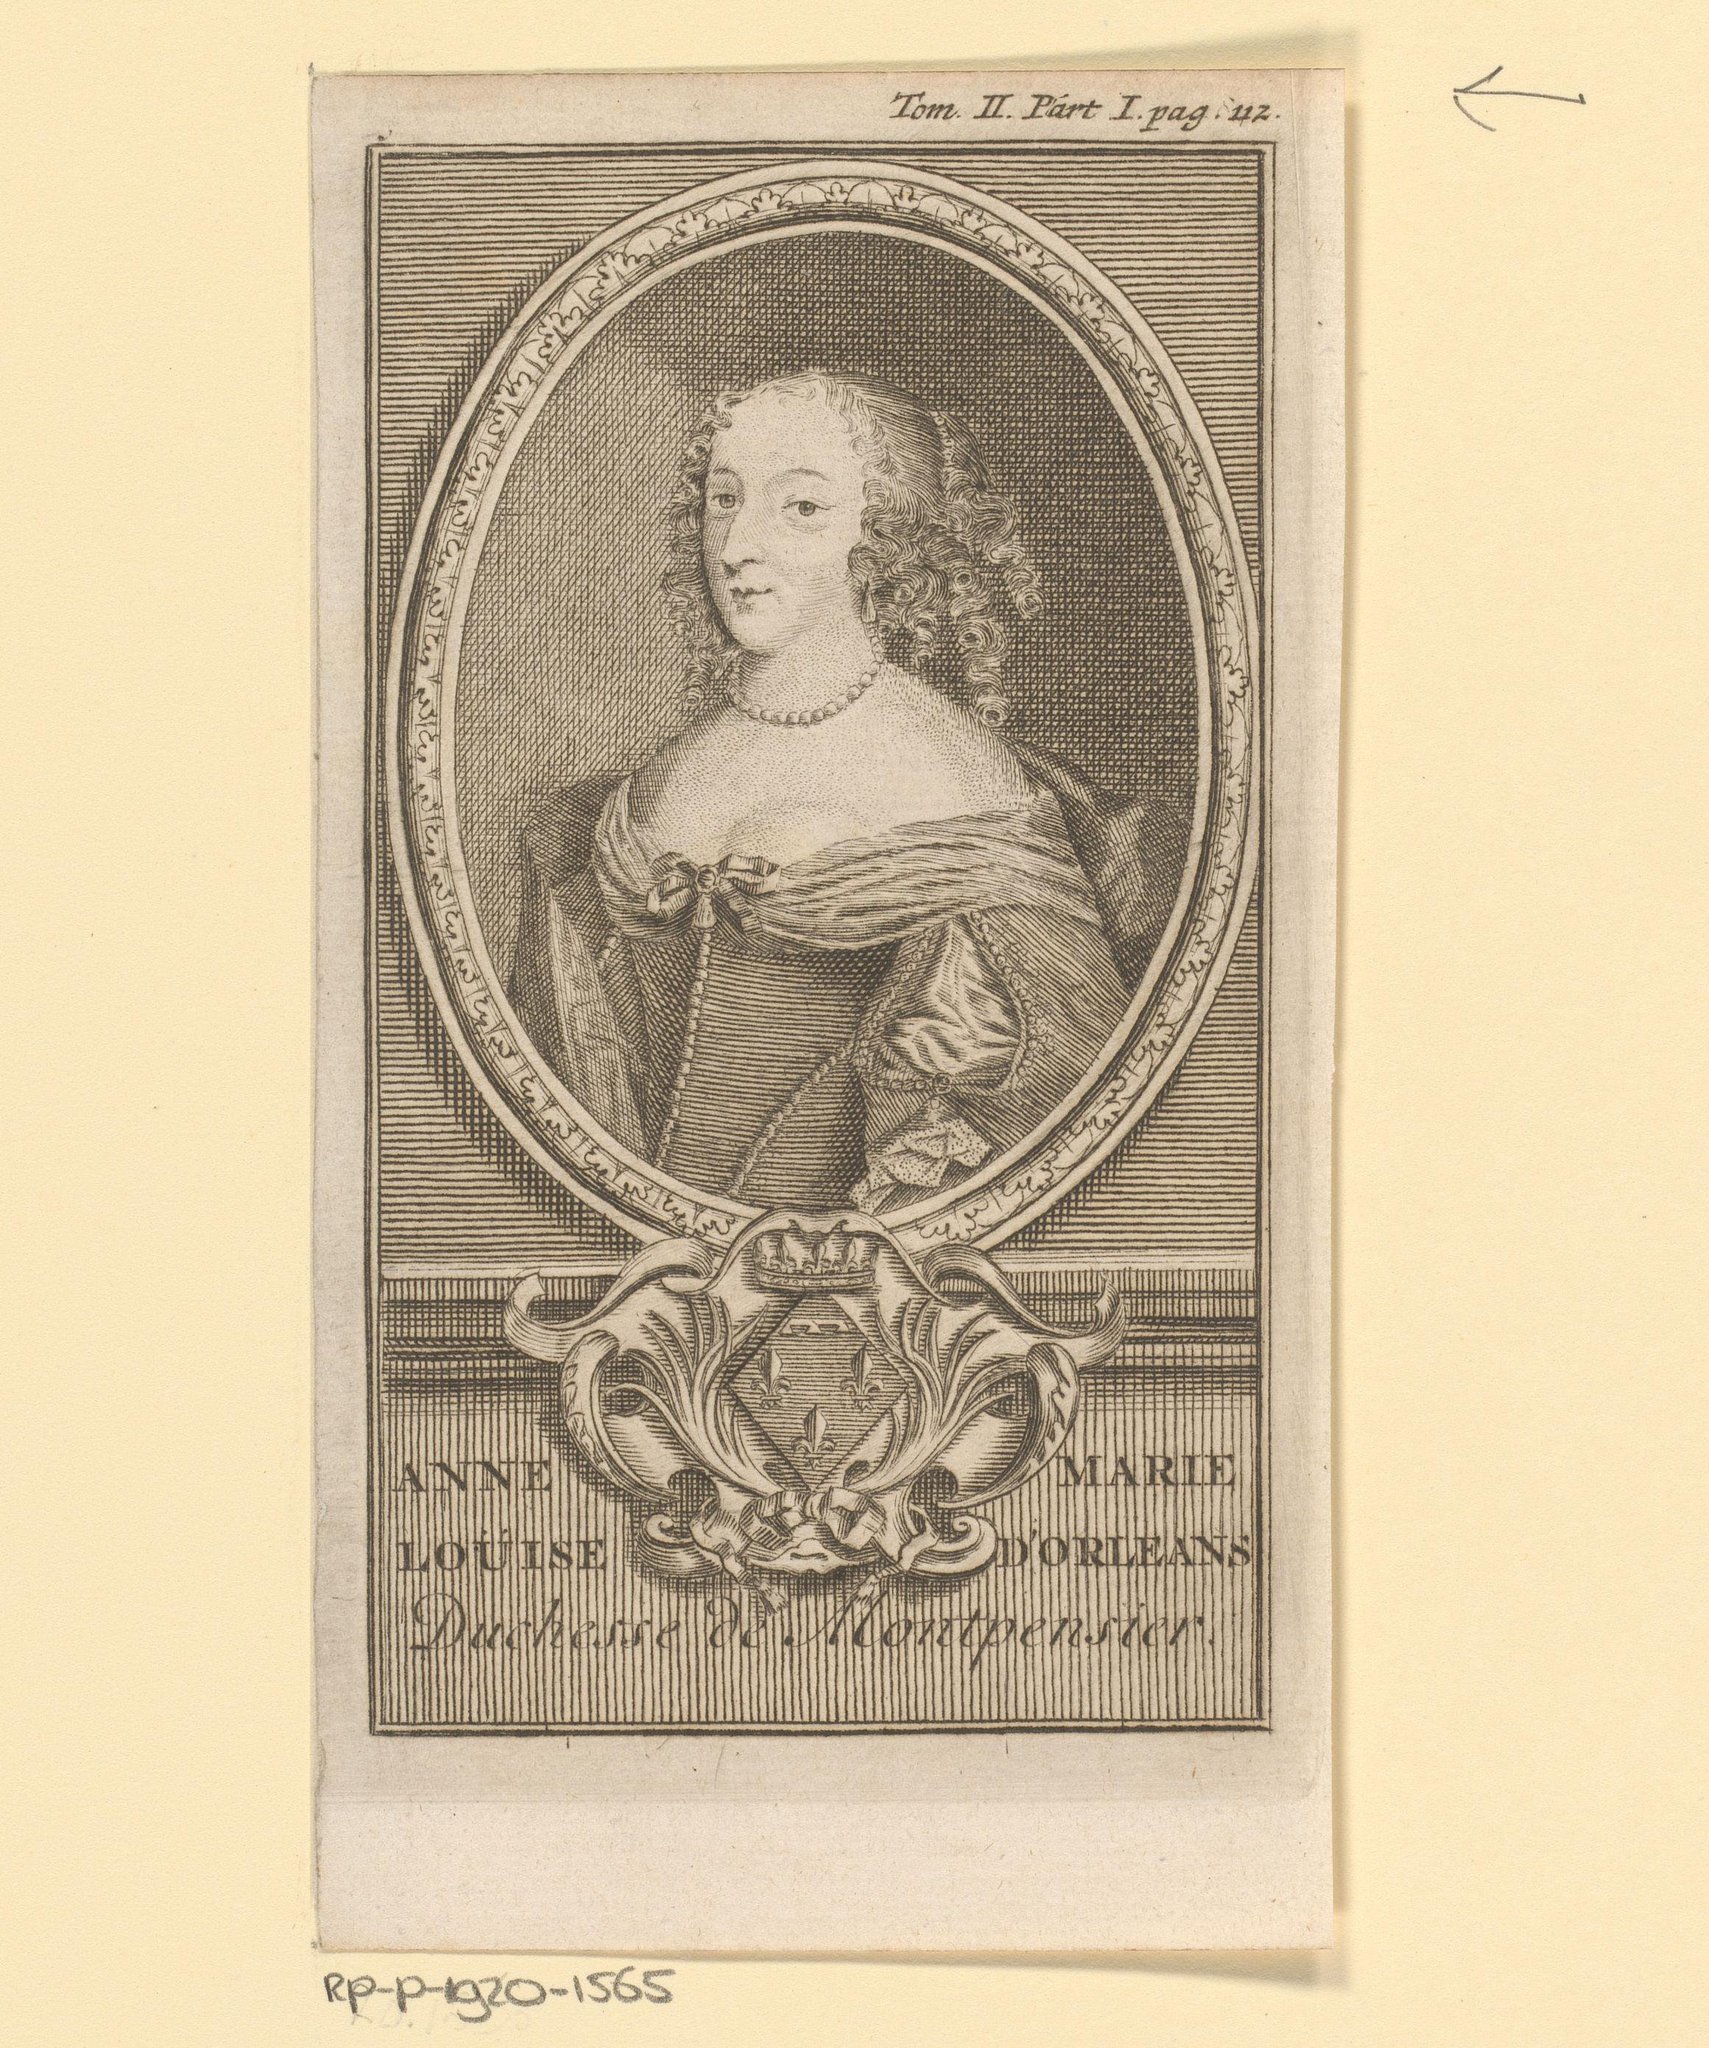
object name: book illustration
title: Anne Marie Loüise d'Orleans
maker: Anonymous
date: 1650-1800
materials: paper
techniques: engraving, etching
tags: anne marie louise d' orléans (hertogin van montpensier), historical persons - bb - woman, ruler, sovereign - bb - female ruler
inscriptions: collector's mark: Lugt 2228